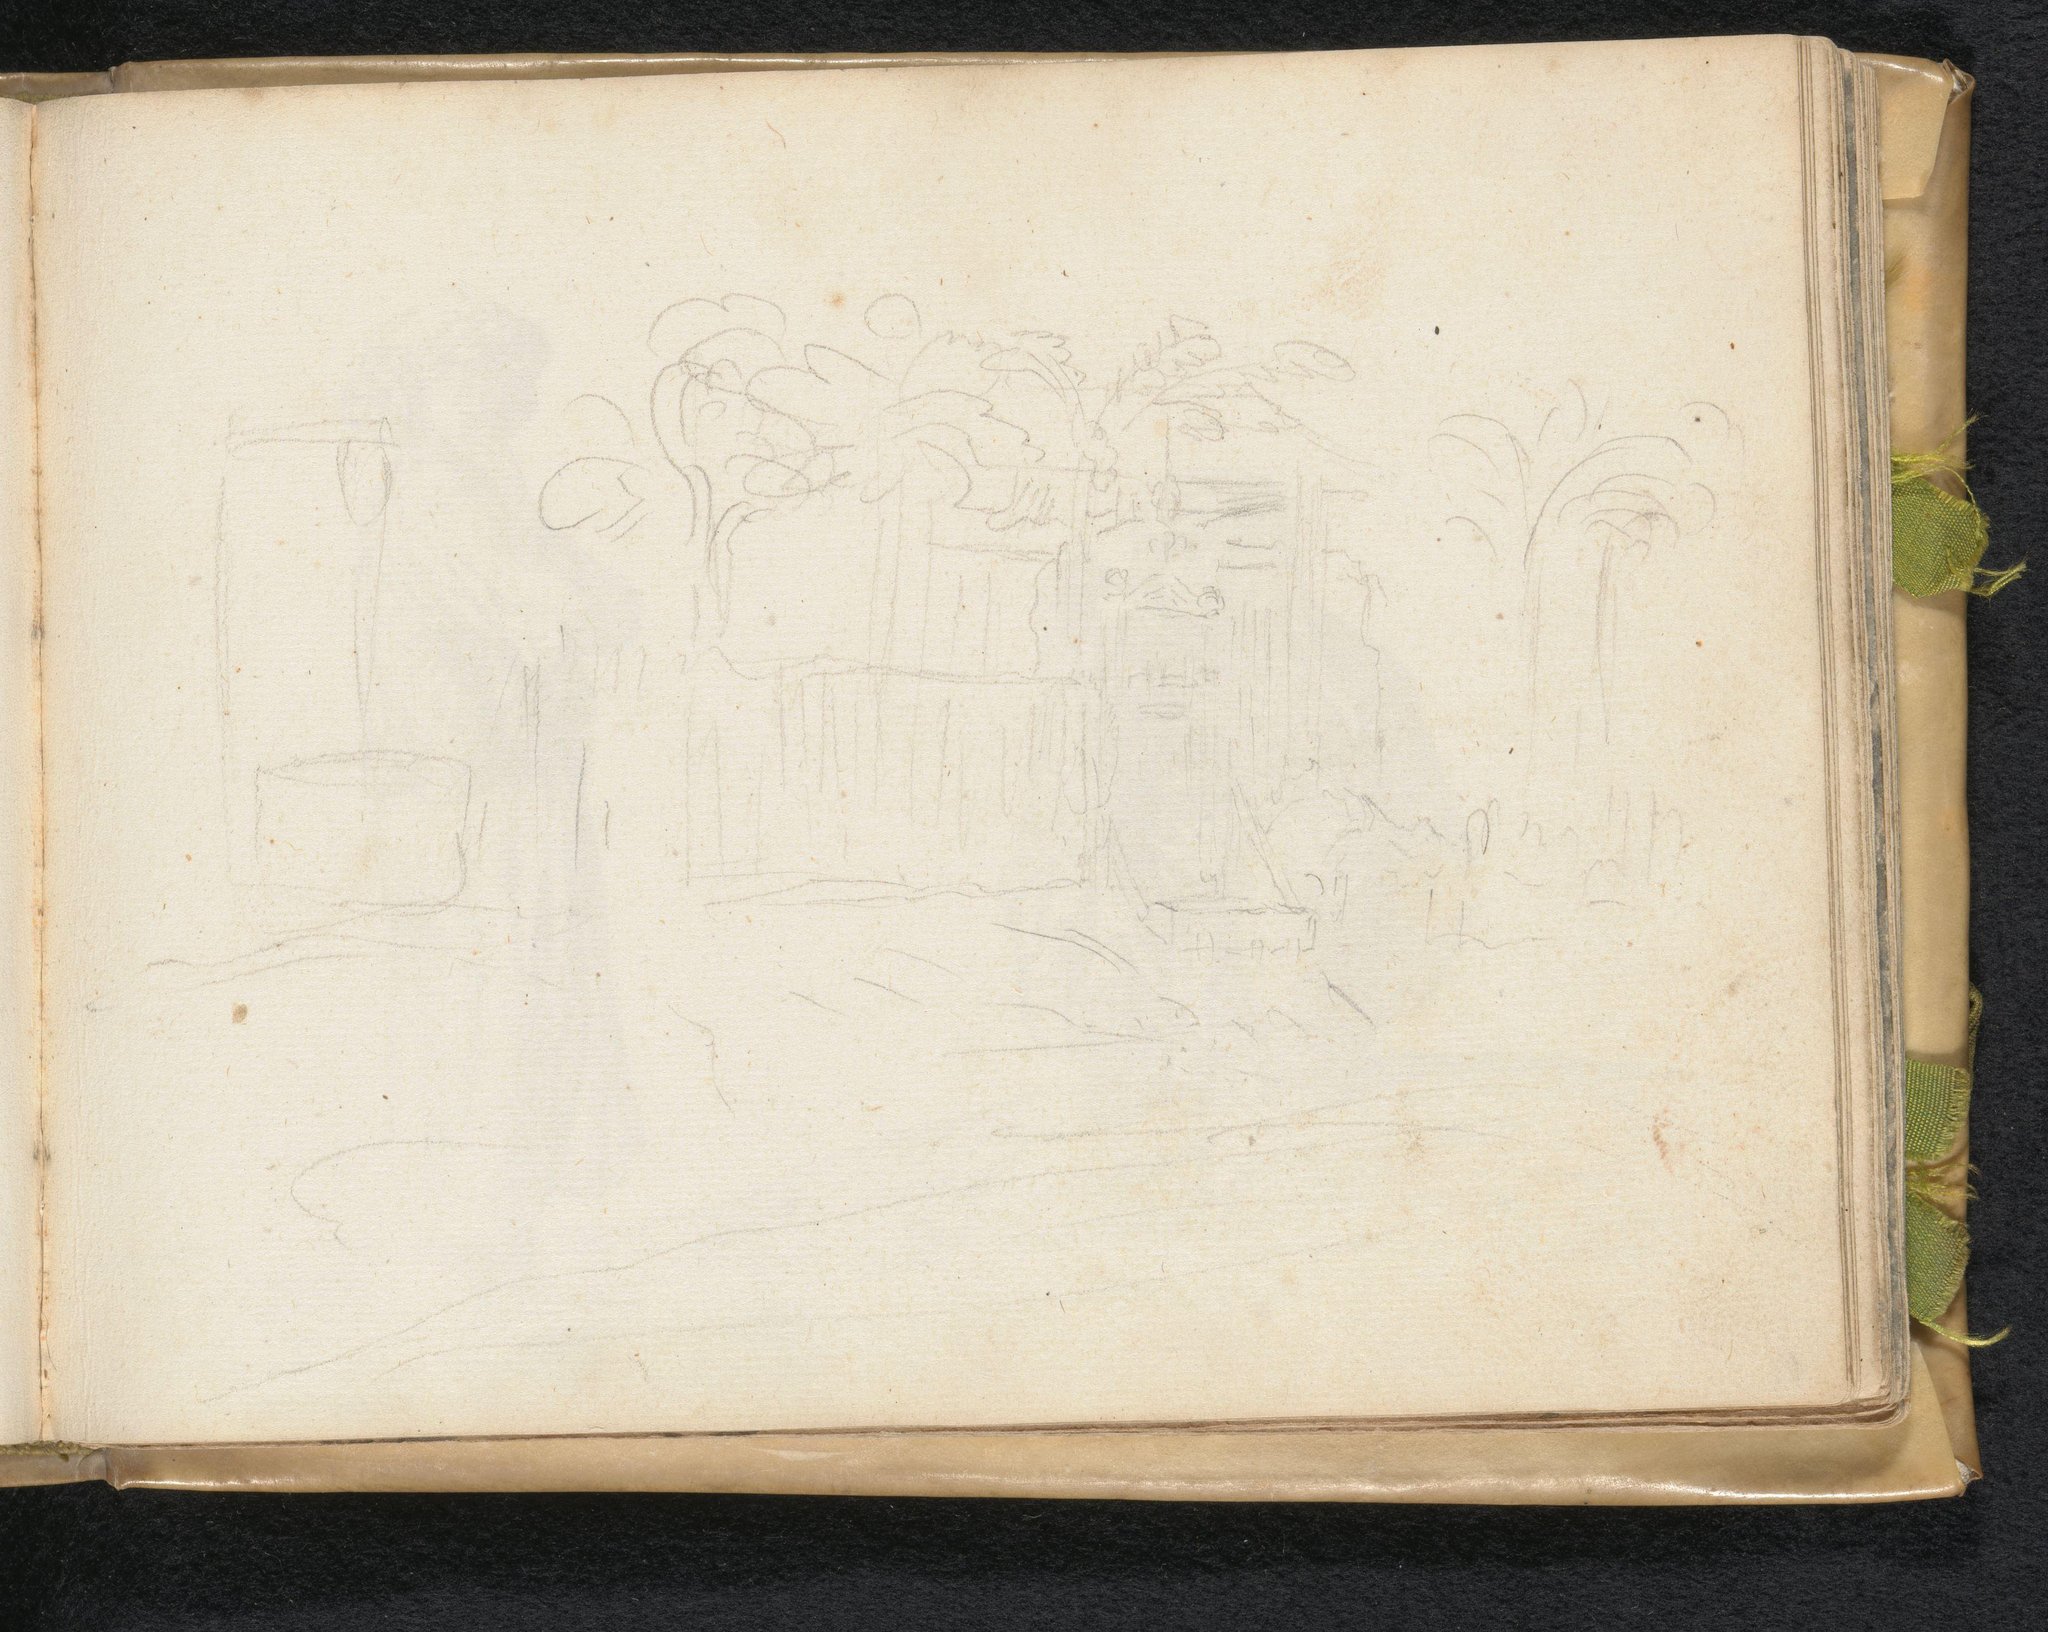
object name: sketchbook leaf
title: Unfinished sketch of buildings and trees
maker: esaias boursse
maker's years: 1631-1672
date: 1662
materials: ink, paper, pencil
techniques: brush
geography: sri lanka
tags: sri lanka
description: Een onafgemaakte schets van een weg met bebouwing en begroeiing. Blad 88 uit een schetsboek met 117 bladen.